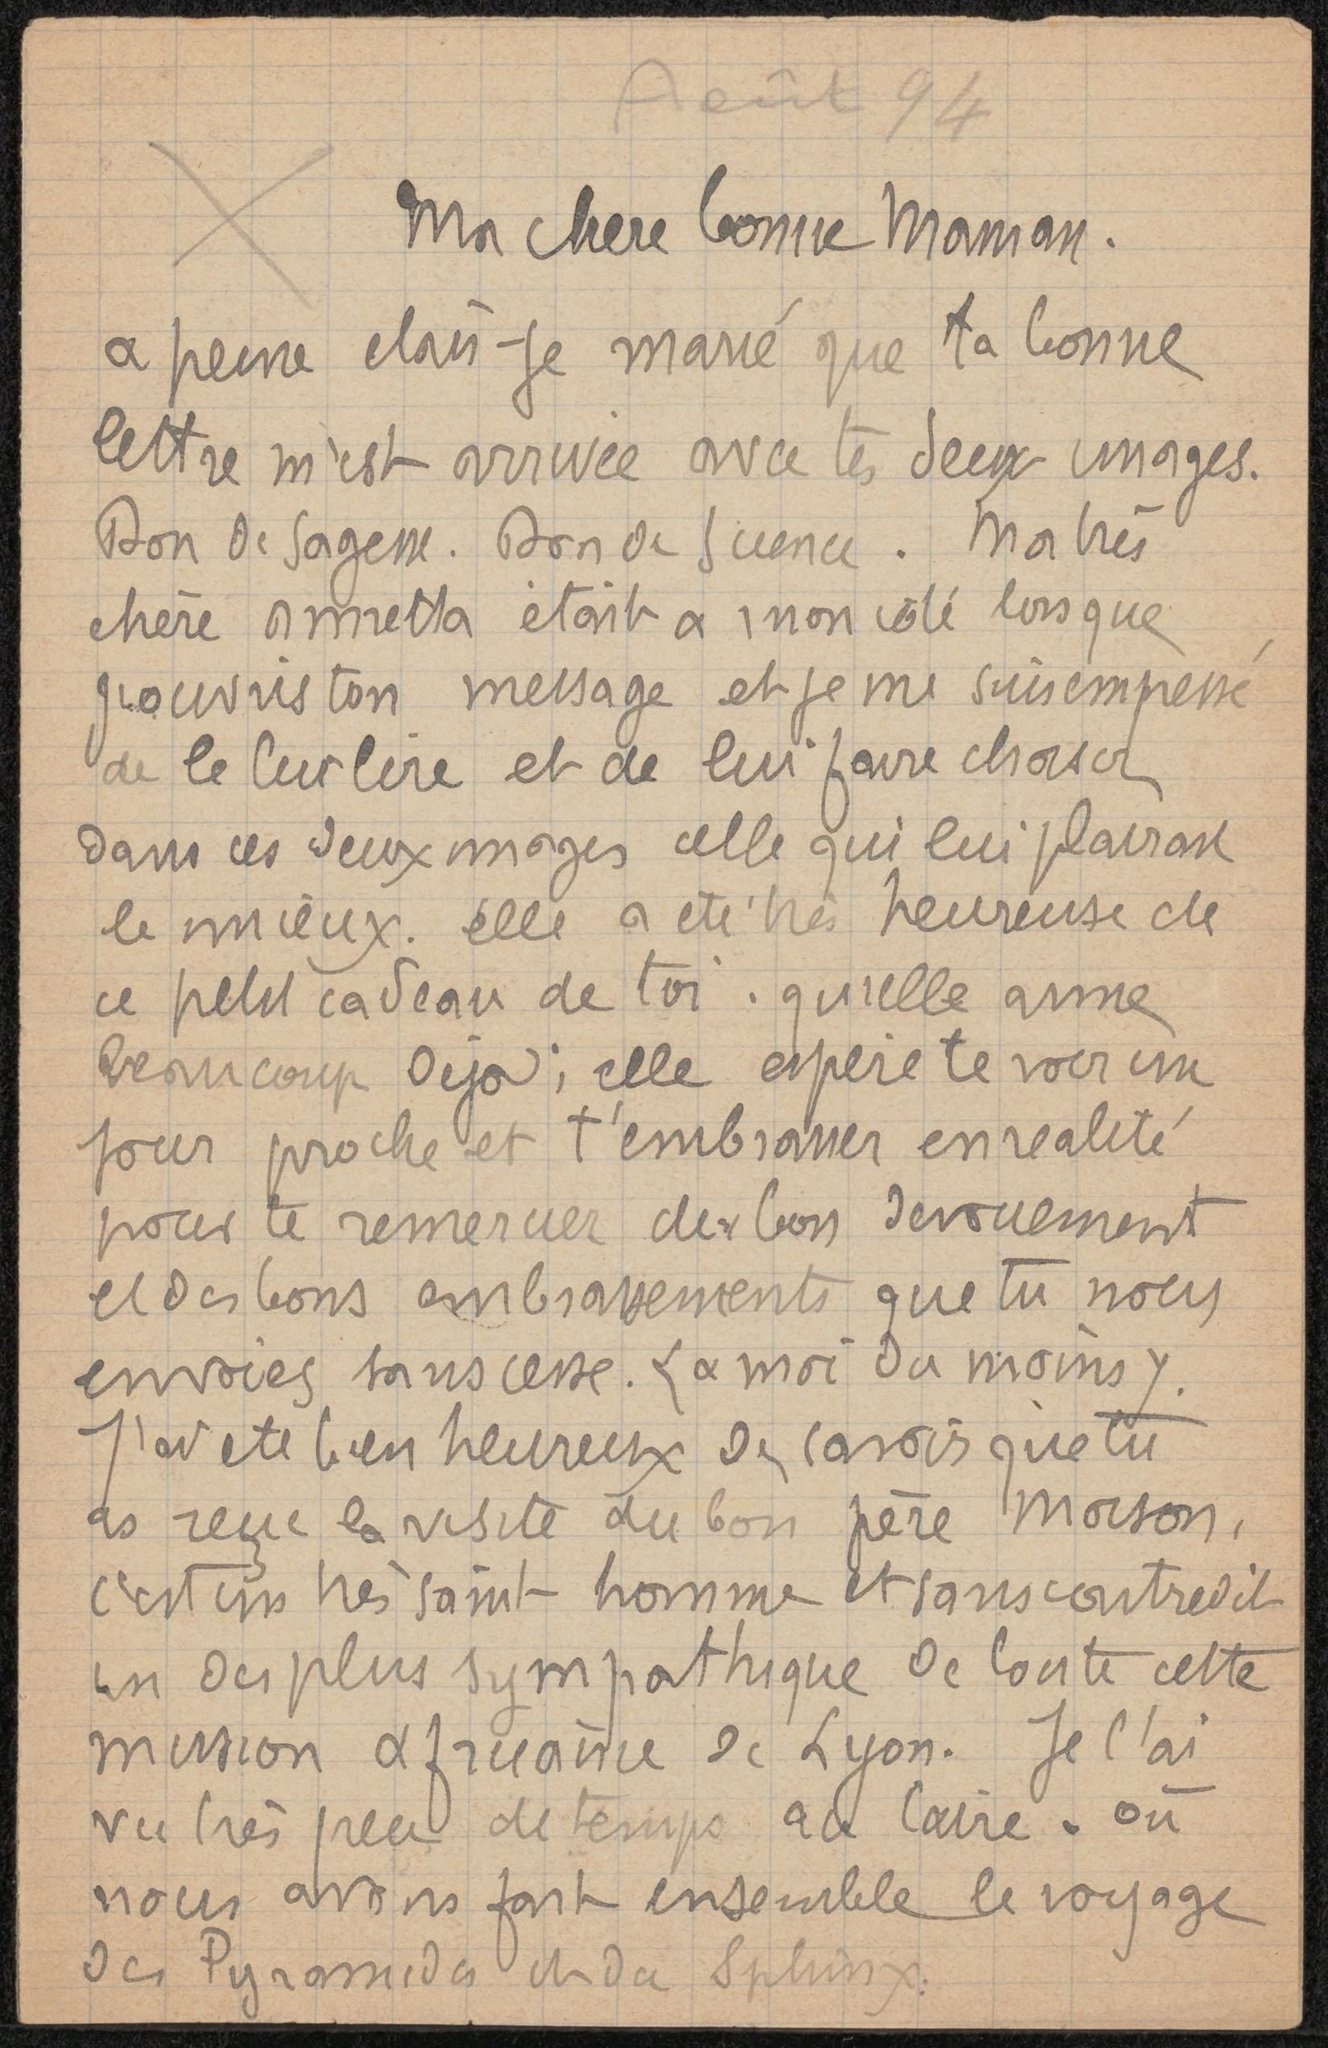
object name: letter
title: Brief aan Sophie Bodin-Lallement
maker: émile bernard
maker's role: print maker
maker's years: 1868-1941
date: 1878-1941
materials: ink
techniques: pen, writing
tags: sophie bodin-lallement